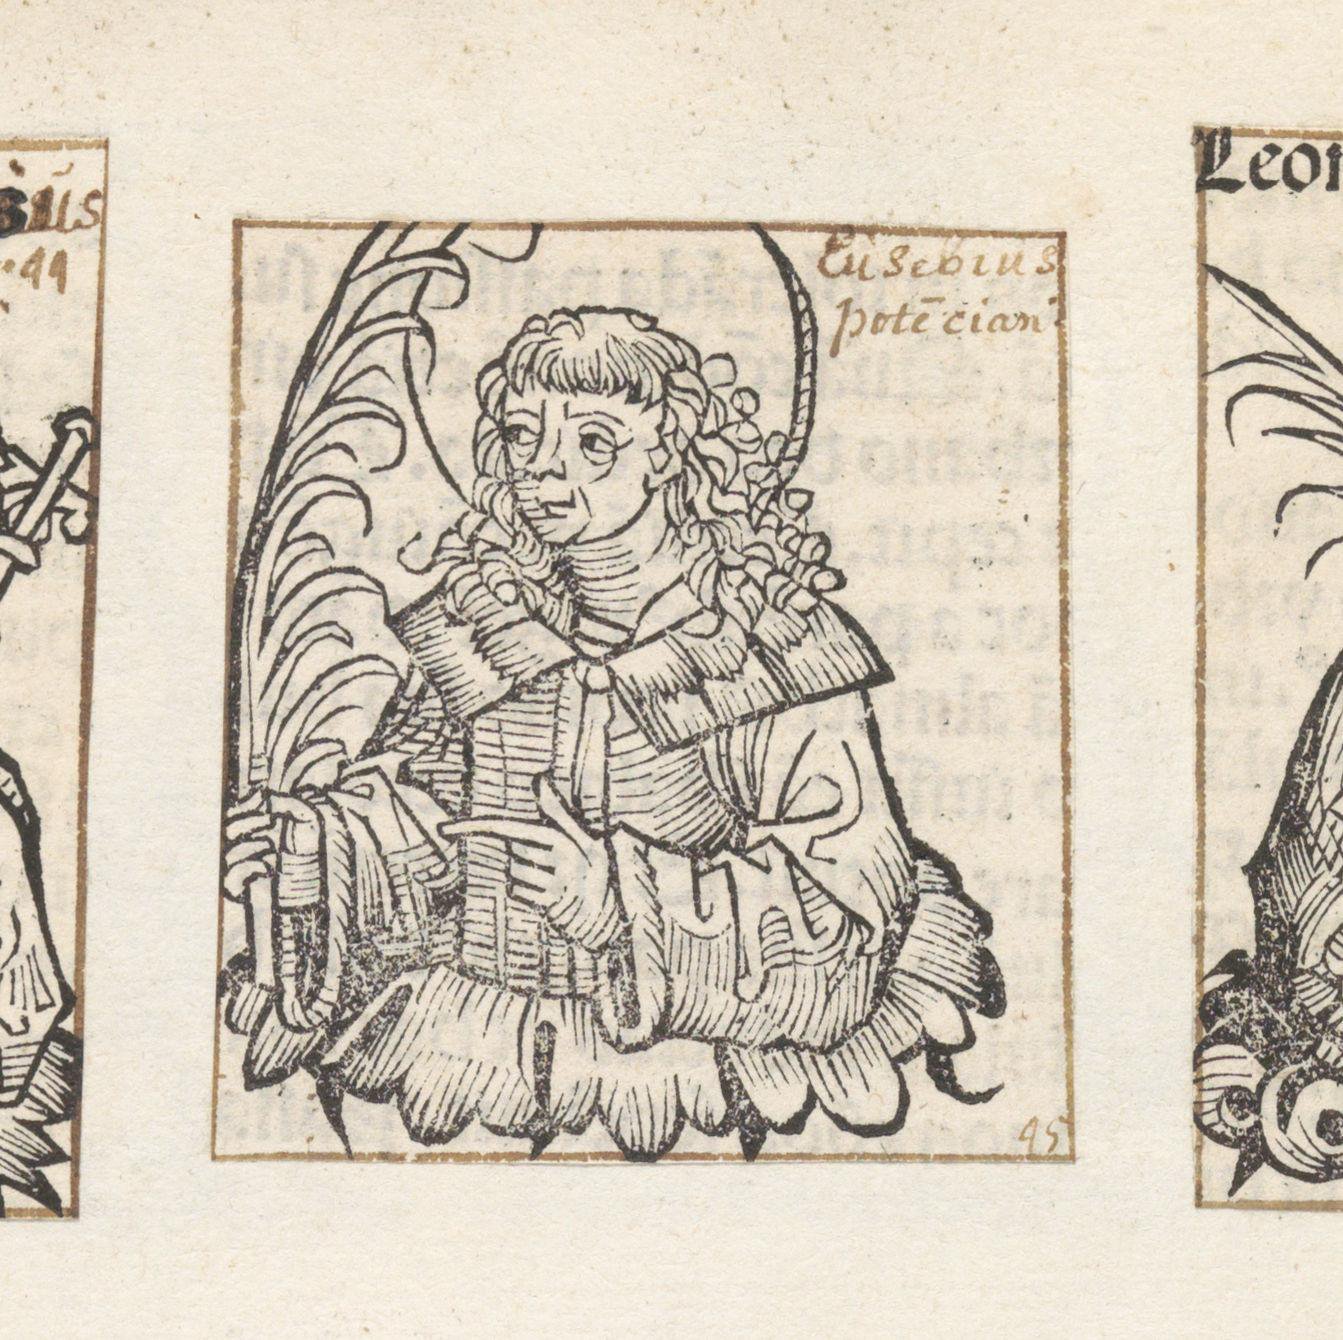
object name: print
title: Liber Chronicarum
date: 1493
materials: paper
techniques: letterpress printing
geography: nuremberg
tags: nimbus, halo ~ radiance emanating from persons or things, saints, martyr(s) (often with palm-branches)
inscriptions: inscription: ‘45 / Eusebius pote[n]cian[us]’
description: De houtsnede wordt herhaaldelijk gebruikt als boekillustratie in de Liber Chronicarum (of Neurenbergkroniek) van Hartmann Schedel, verschenen in het Latijn en Duits in 1493. Zie de Latijnse uitgave, folio 116r.